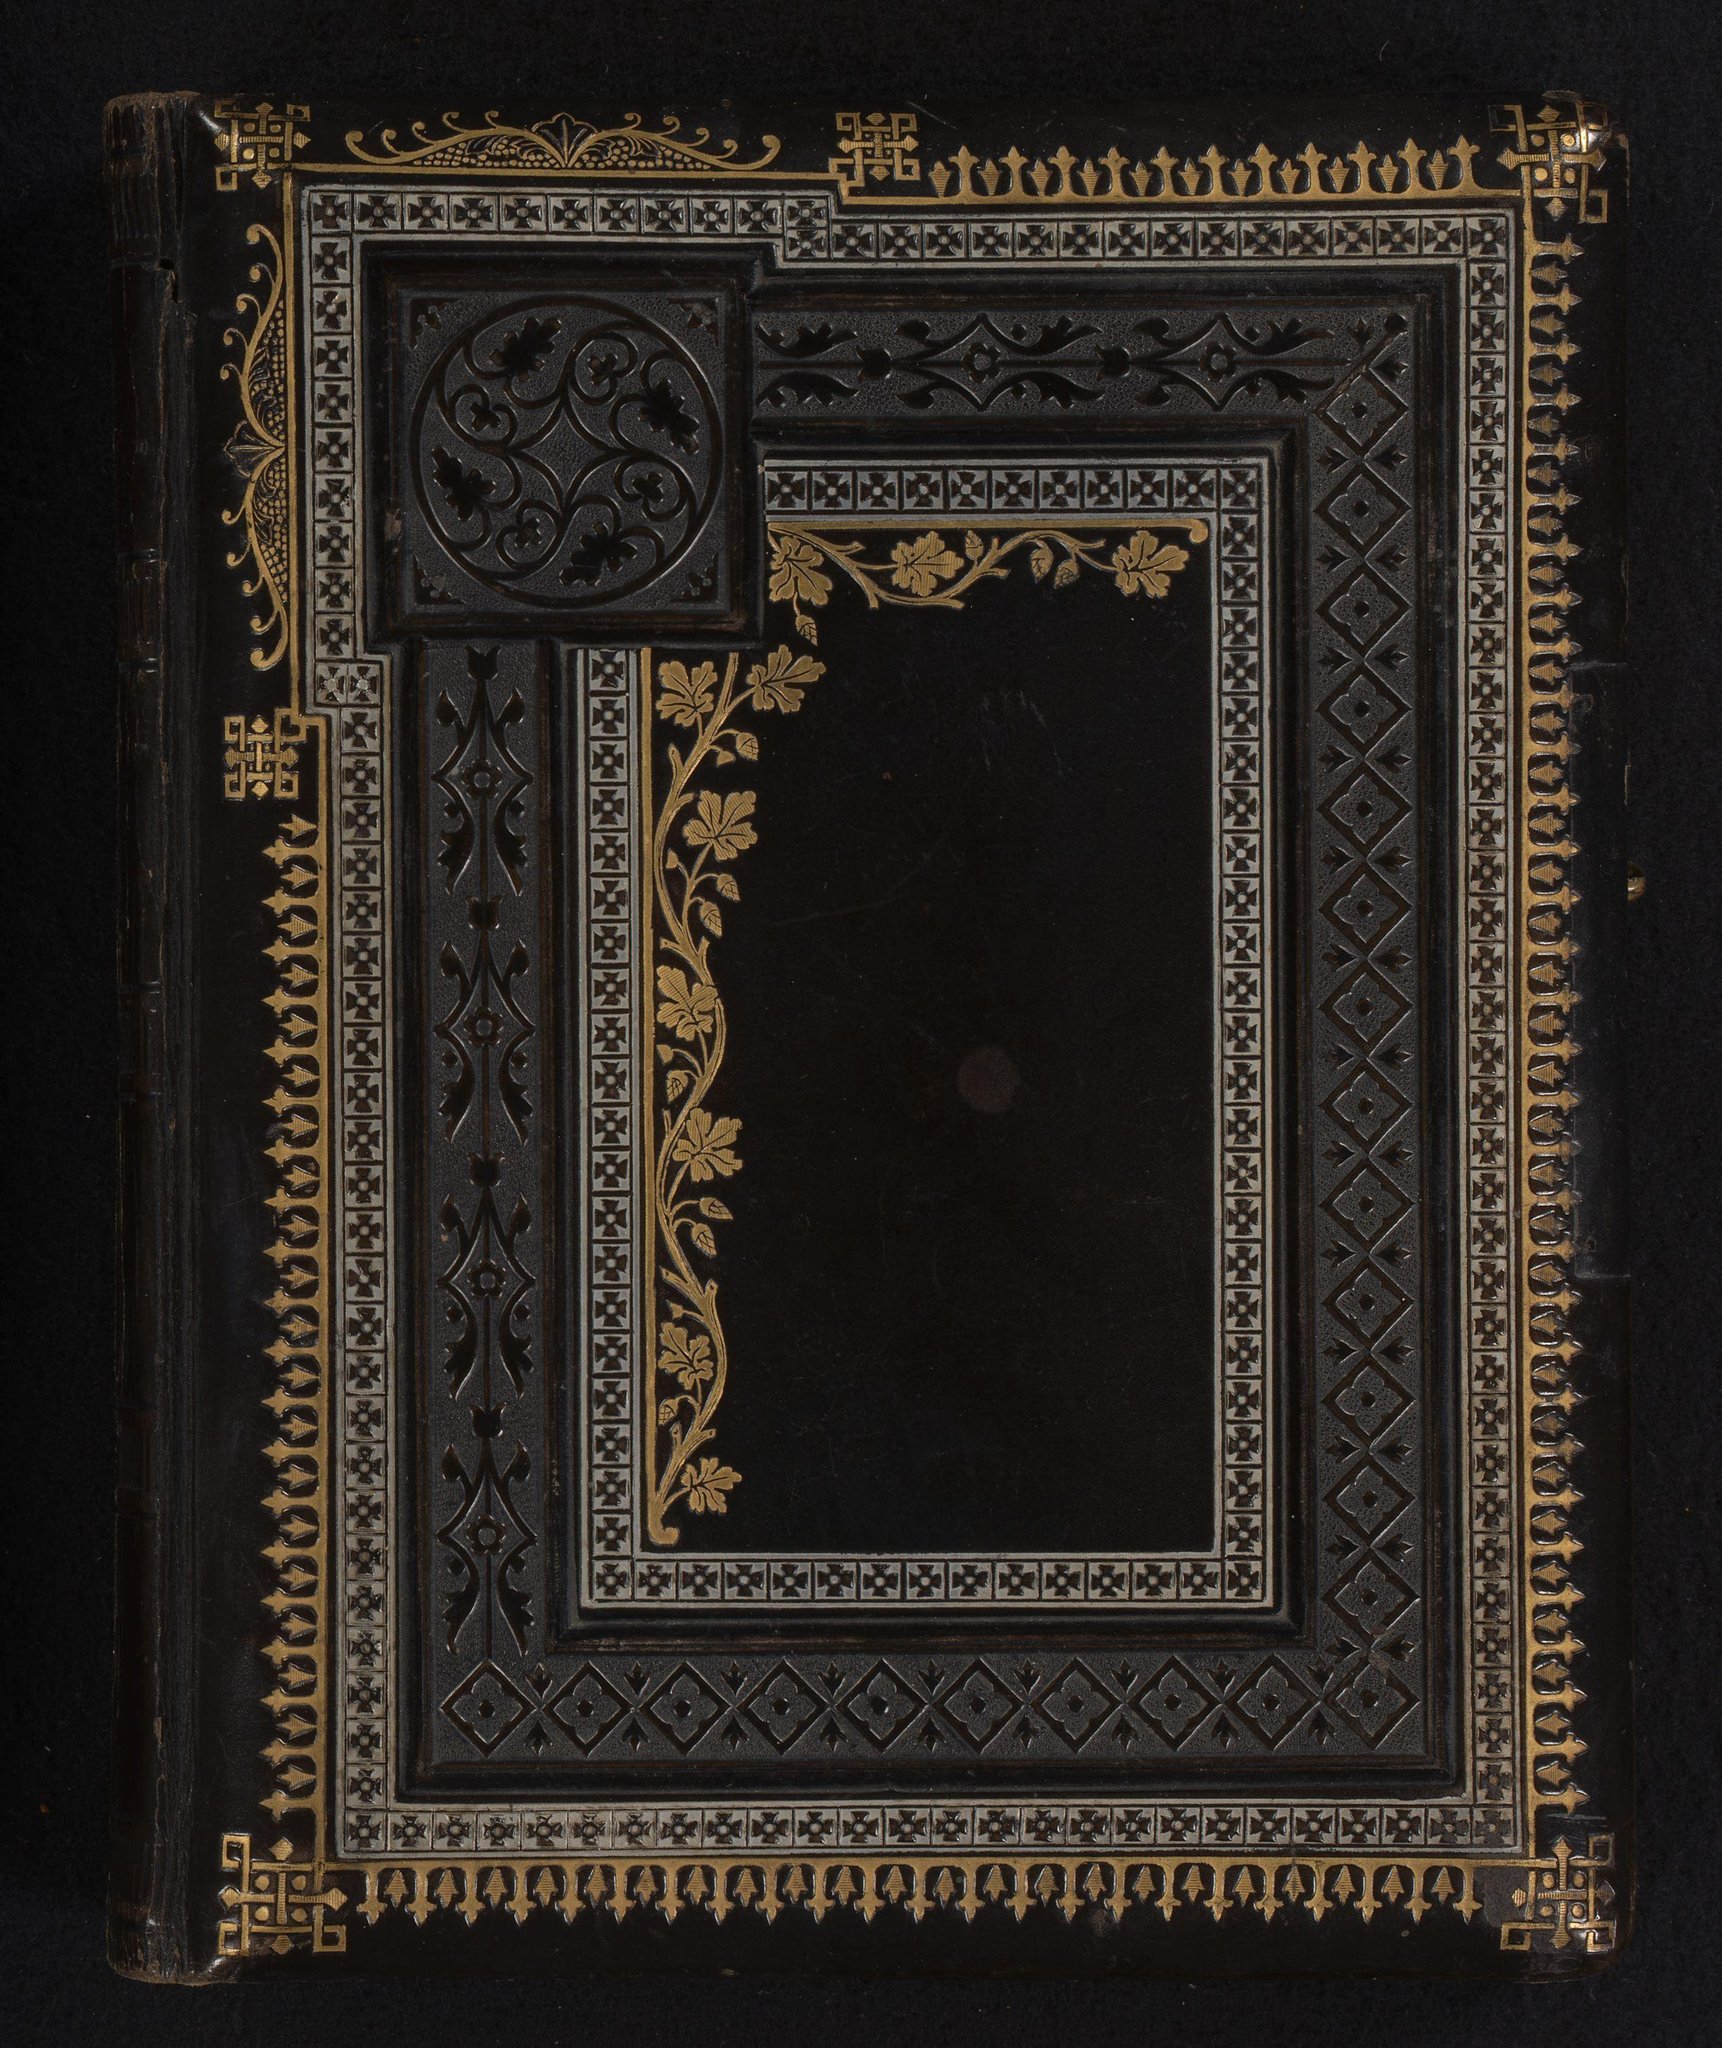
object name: photograph album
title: Fotoalbum (leeg)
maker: Anonymous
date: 1860-1900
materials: cardboard, leather, metal, paper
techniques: color on snow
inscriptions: collector's mark: ‘DIENST/ VERSPREIDE/ RIJKSKOLLEKTIES/ (...) A 856’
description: Fotoalbum met veertig pagina's met op iedere pagina een met gouden lijnen omkaderde passe-partout voor een kabinetfoto.